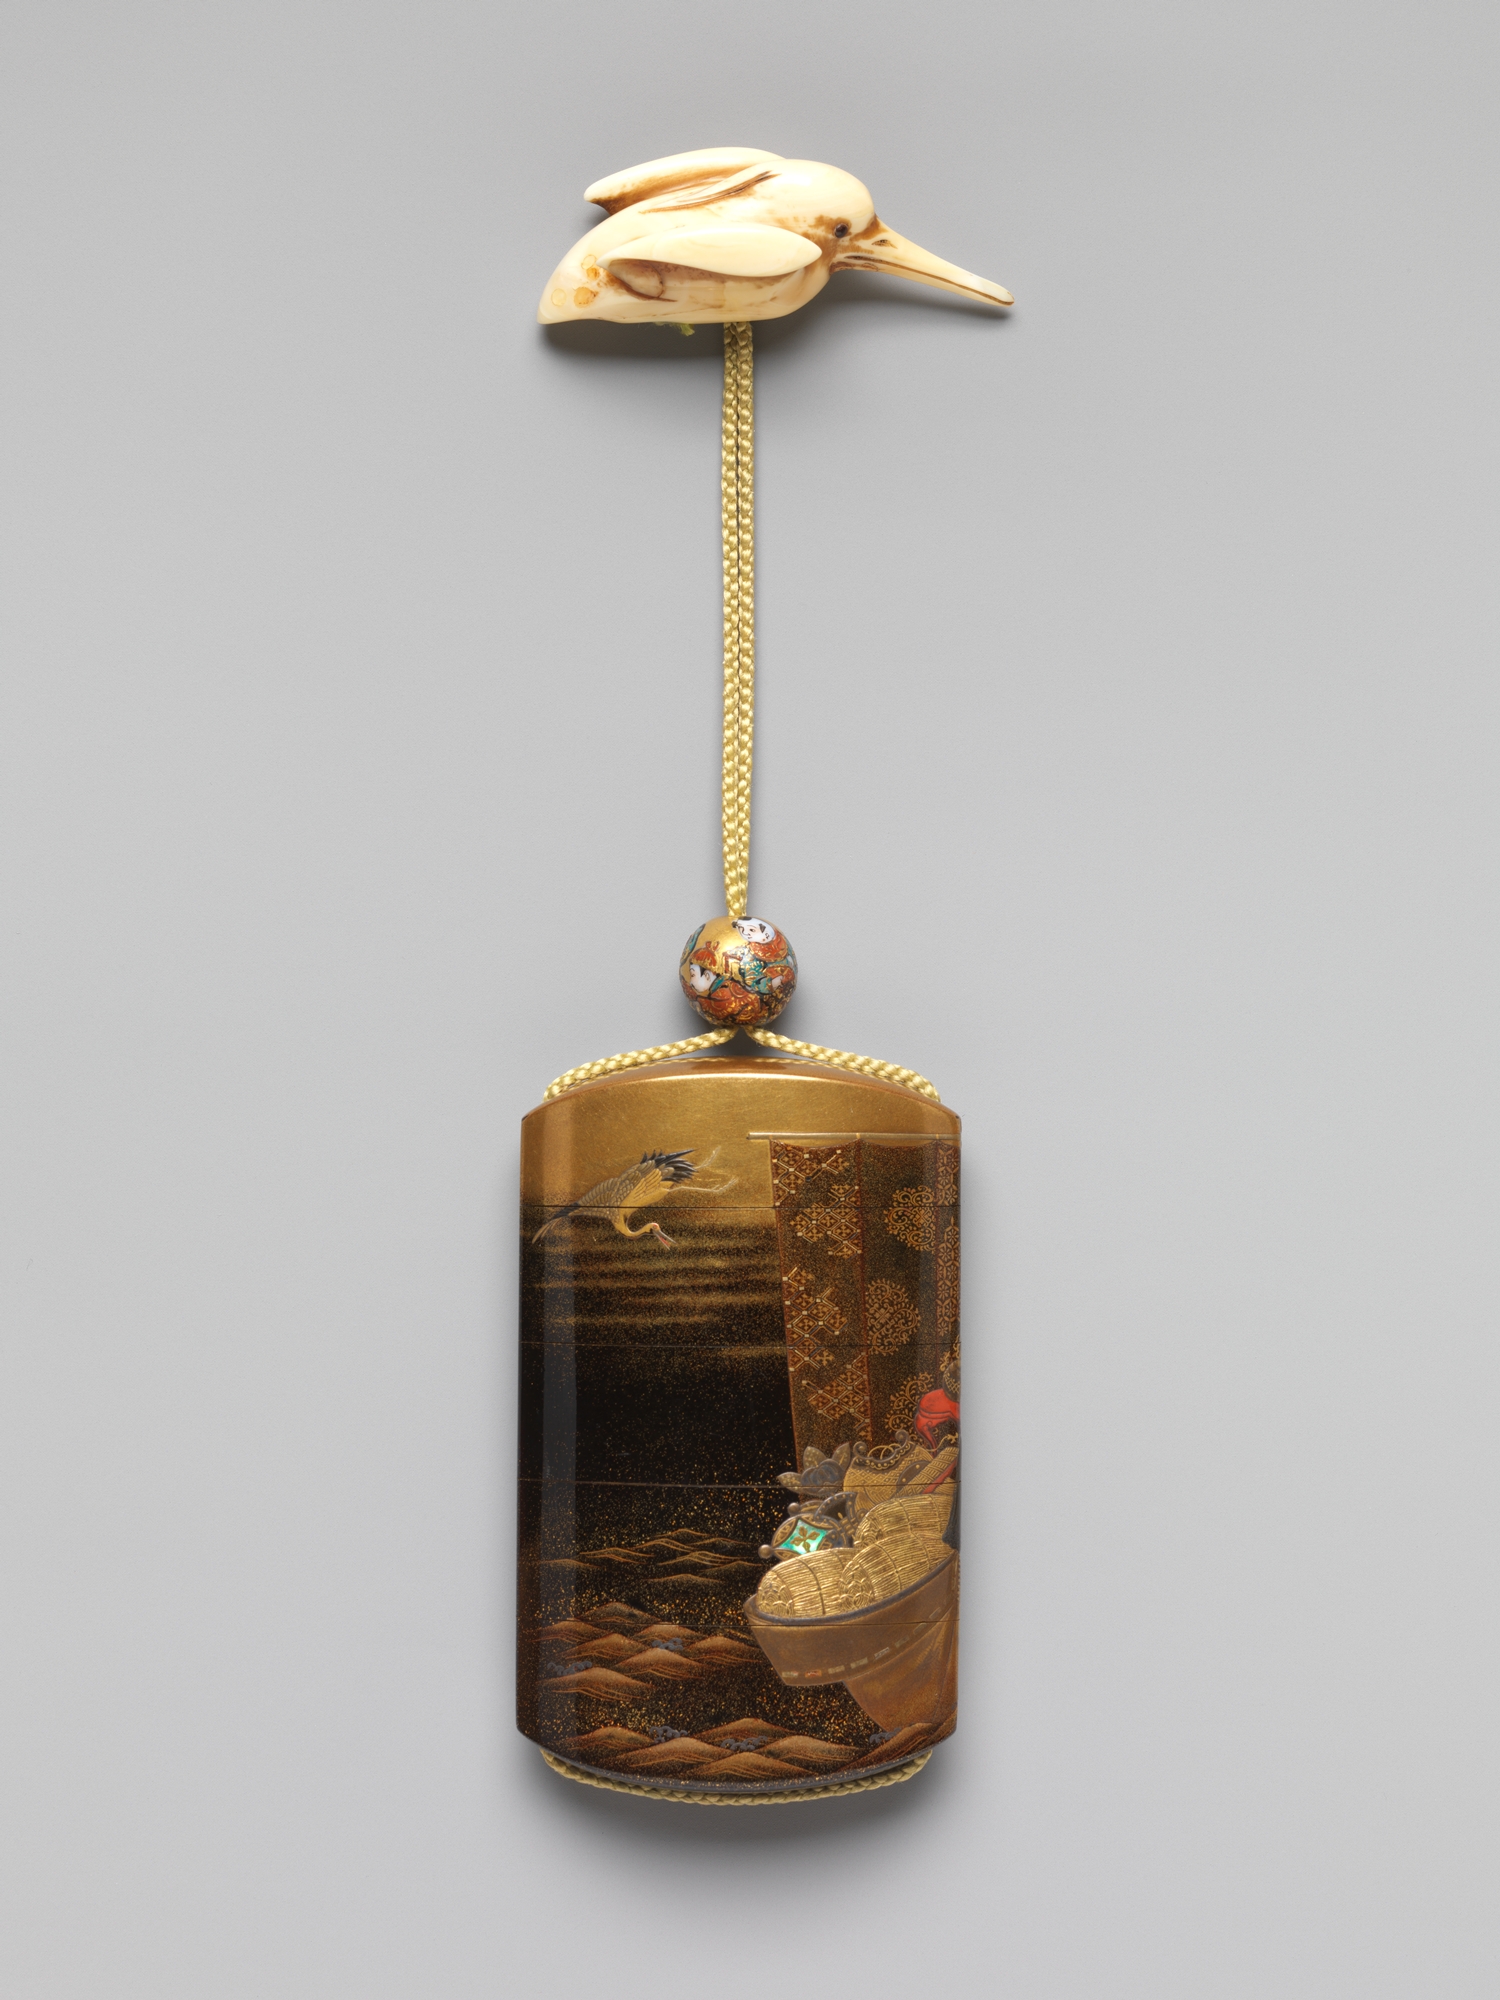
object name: inrō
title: Inrō with Treasure Boat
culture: japanese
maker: kajikawa bunryūsai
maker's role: artist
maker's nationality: japanese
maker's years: 1741-1827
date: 1801-1900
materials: gold, ivory, lacquer, mother of pearl, porcelain, silver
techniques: carving, hiramakie, inlay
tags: birds,boats